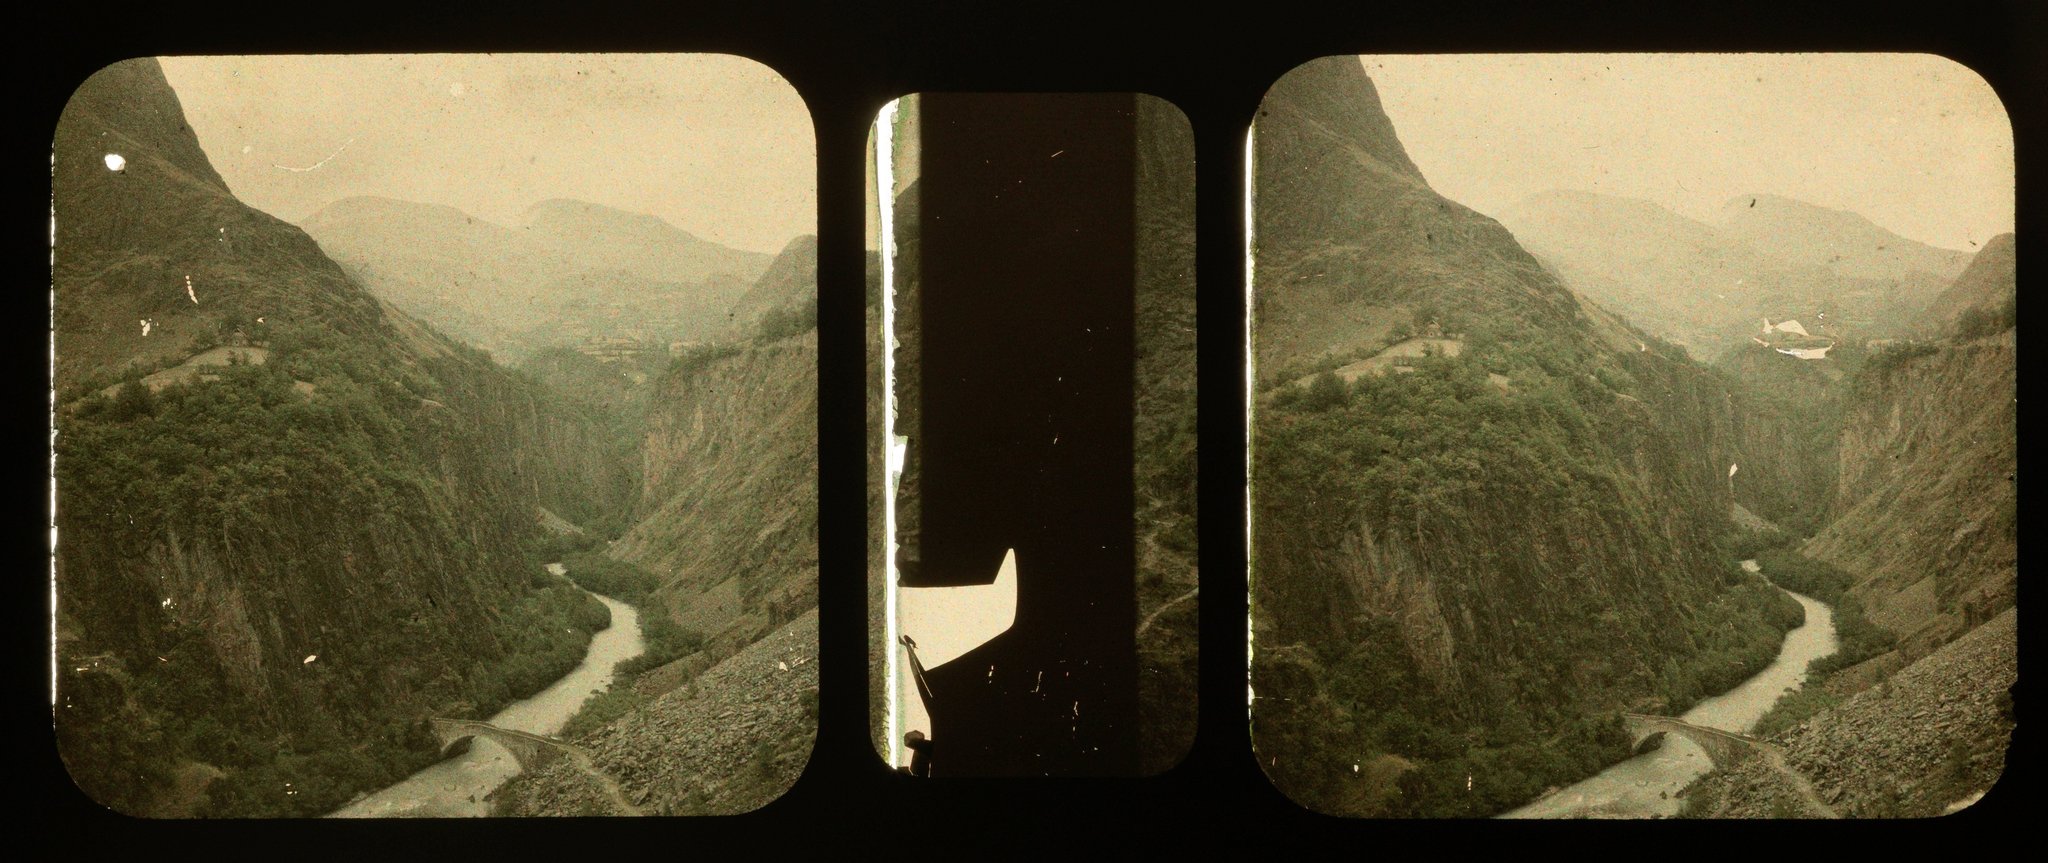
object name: stereoscopic photograph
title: Berglandschap met rivier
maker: adolphe burdet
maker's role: fotograaf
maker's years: 1860-1940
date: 1907-1935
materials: glass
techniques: autochrome process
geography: switzerland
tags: river, mountains, switzerland